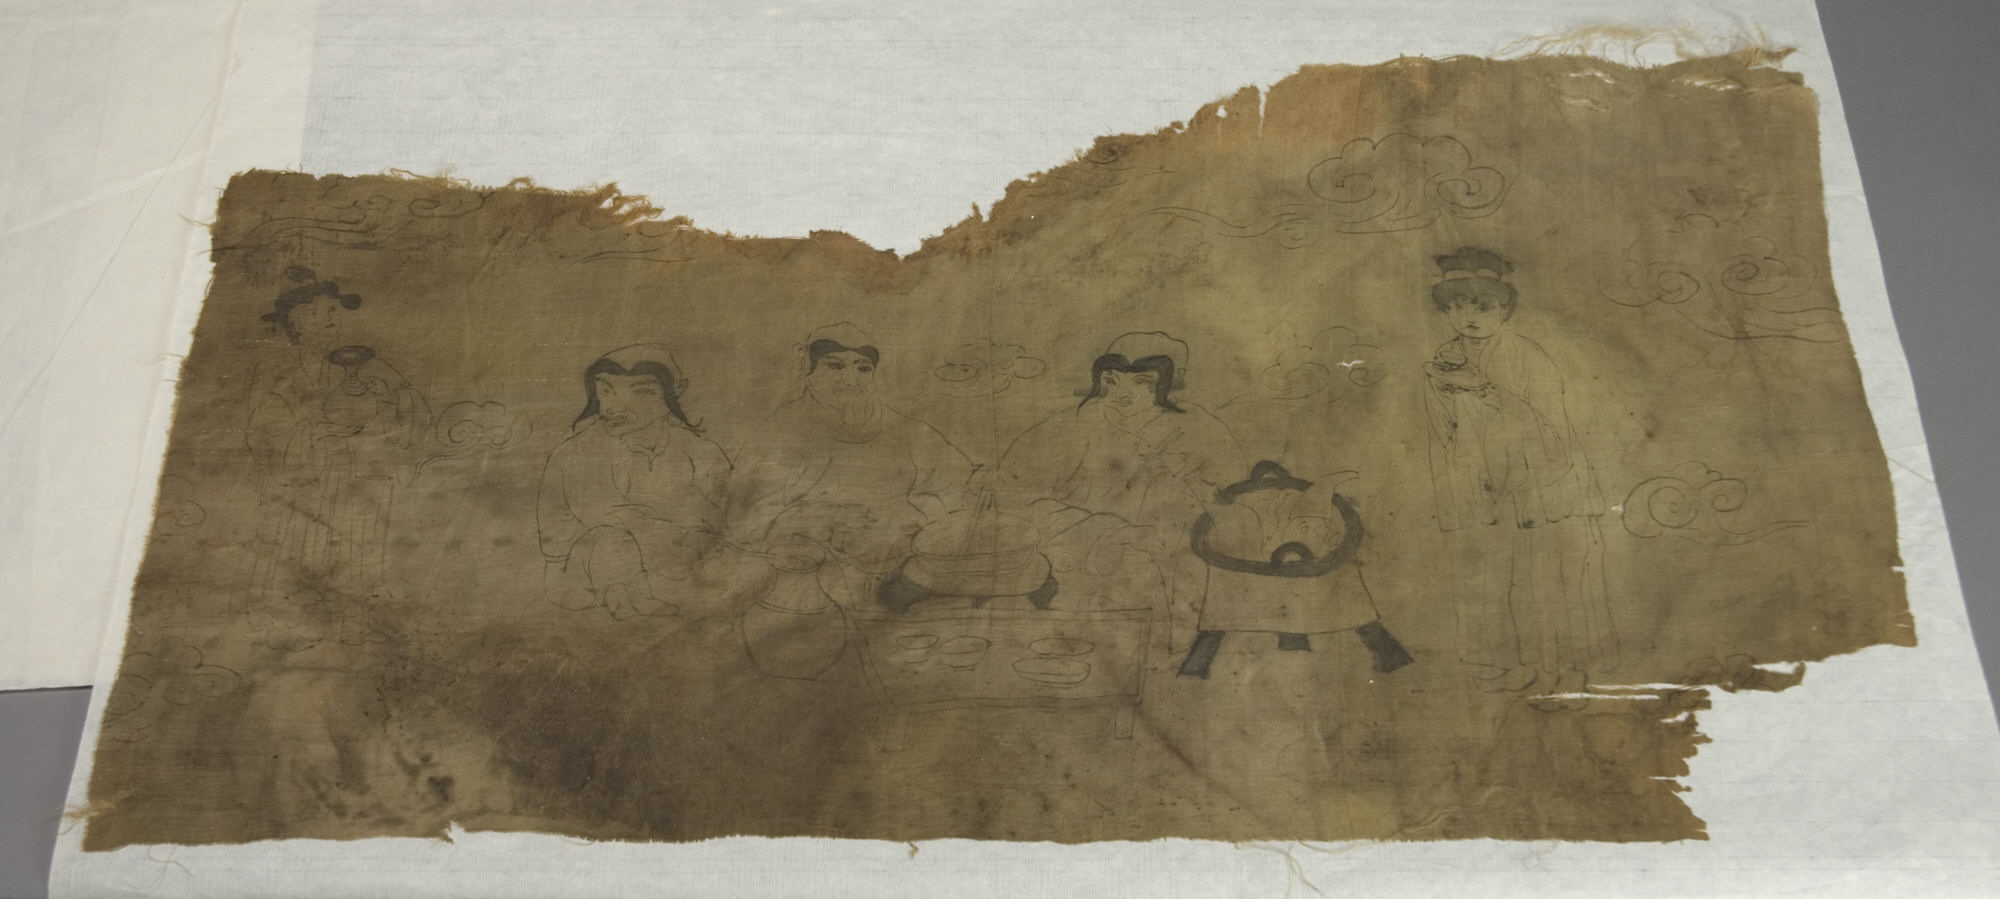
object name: fragment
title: Banquet Scene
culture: chinese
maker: unidentified artist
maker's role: artist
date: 907-1125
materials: ink, silk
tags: food,men,women,banquets